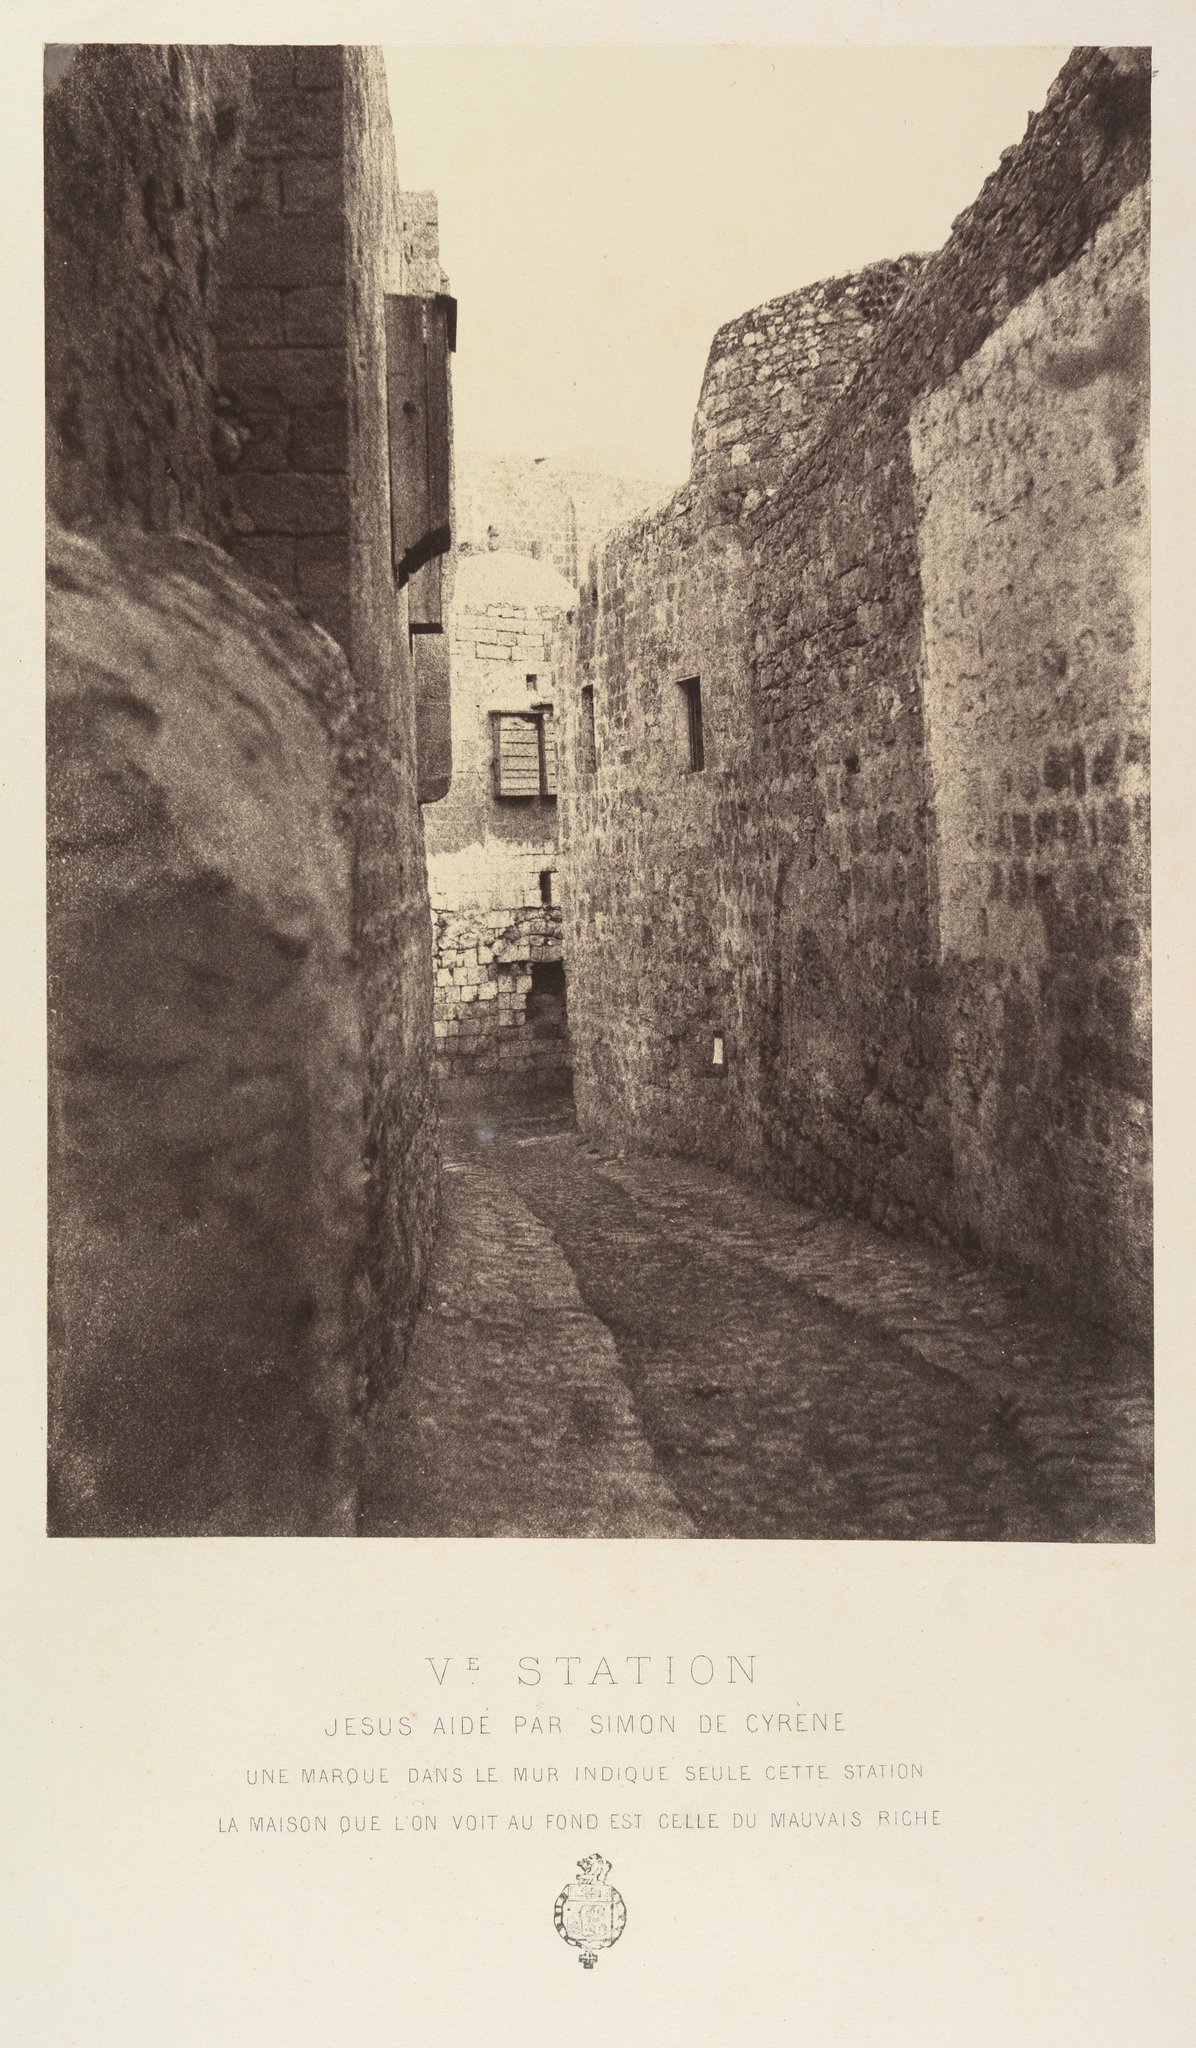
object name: photograph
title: Ve Station. Jésus aidé par Simon de Cyrène. Une marque dans le mur indique seule cette station. La maison que l'on voit au fond est celle du mauvais riche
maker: louis de clercq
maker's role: artist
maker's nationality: french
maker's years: 1837-1901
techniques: albumen silver print, paper negative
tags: architecture